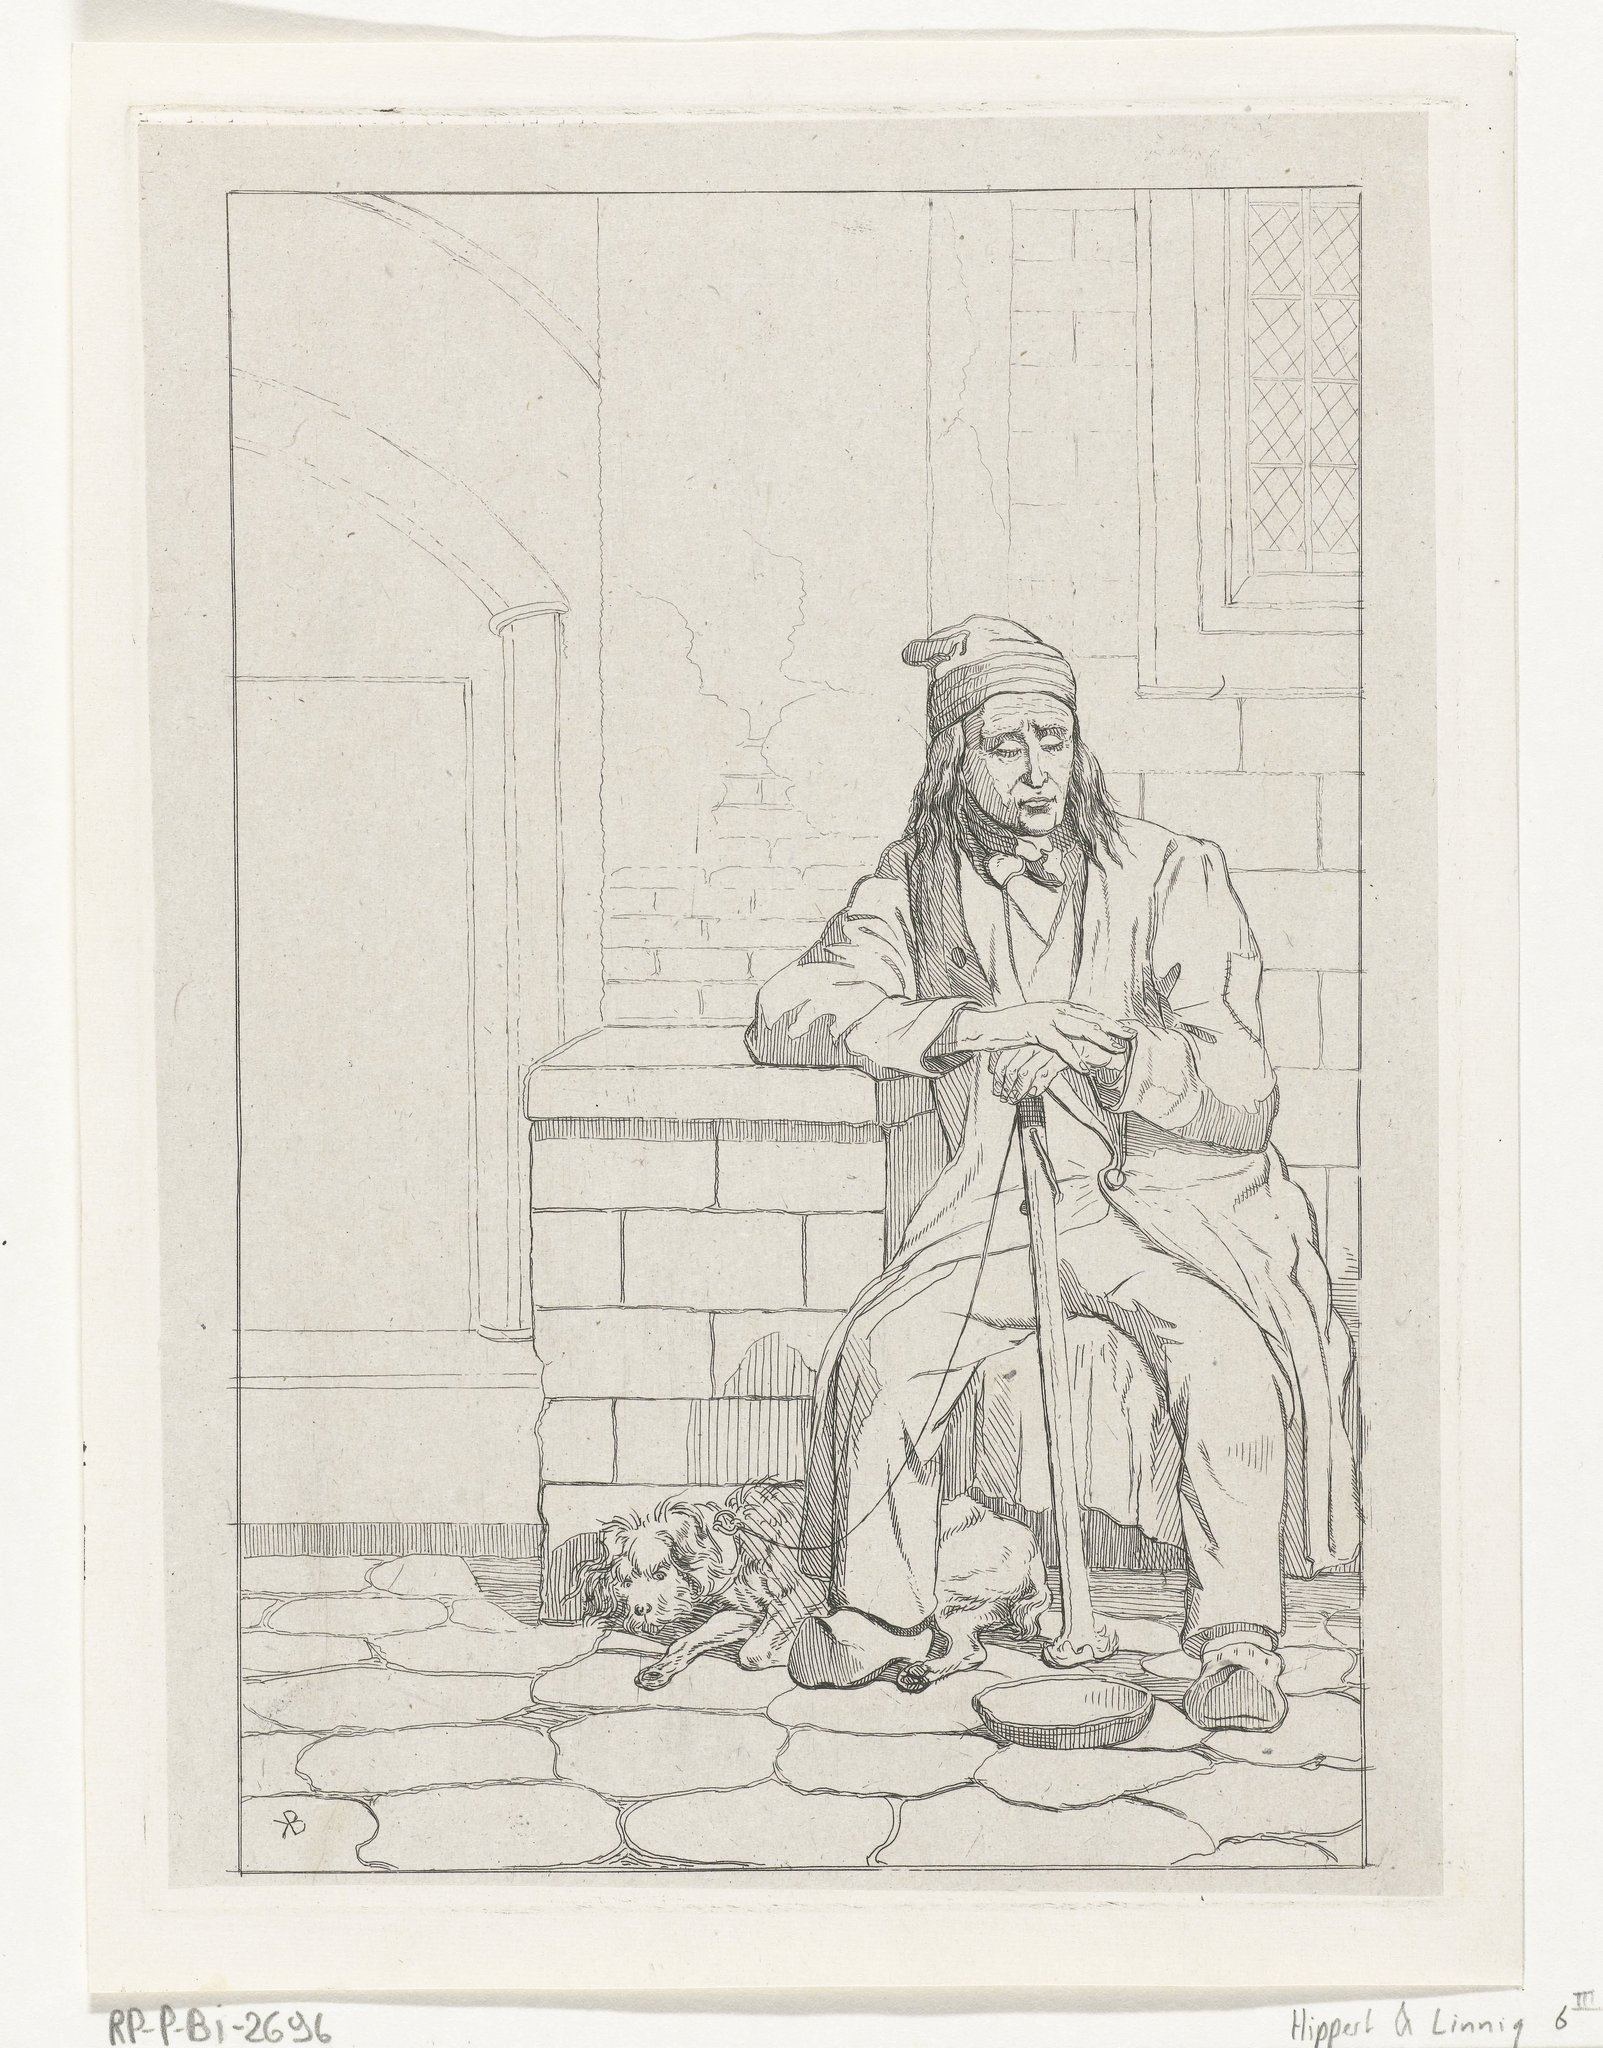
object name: print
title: Bedelaar met hond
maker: karel frederik bombled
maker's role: draughtsman, print maker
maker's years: 1822-1902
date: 1832-1902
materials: paper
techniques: etching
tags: begging bowl, beggar, dog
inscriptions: collector's mark: Lugt 2228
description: Een bedelaar zit op een bankje voor een kerkportaal. Zijn ogen zijn gesloten en hij lijkt te rusten. Een kleine hond ligt naast hem aan de lijn. Voor de man ligt een bedelnap.